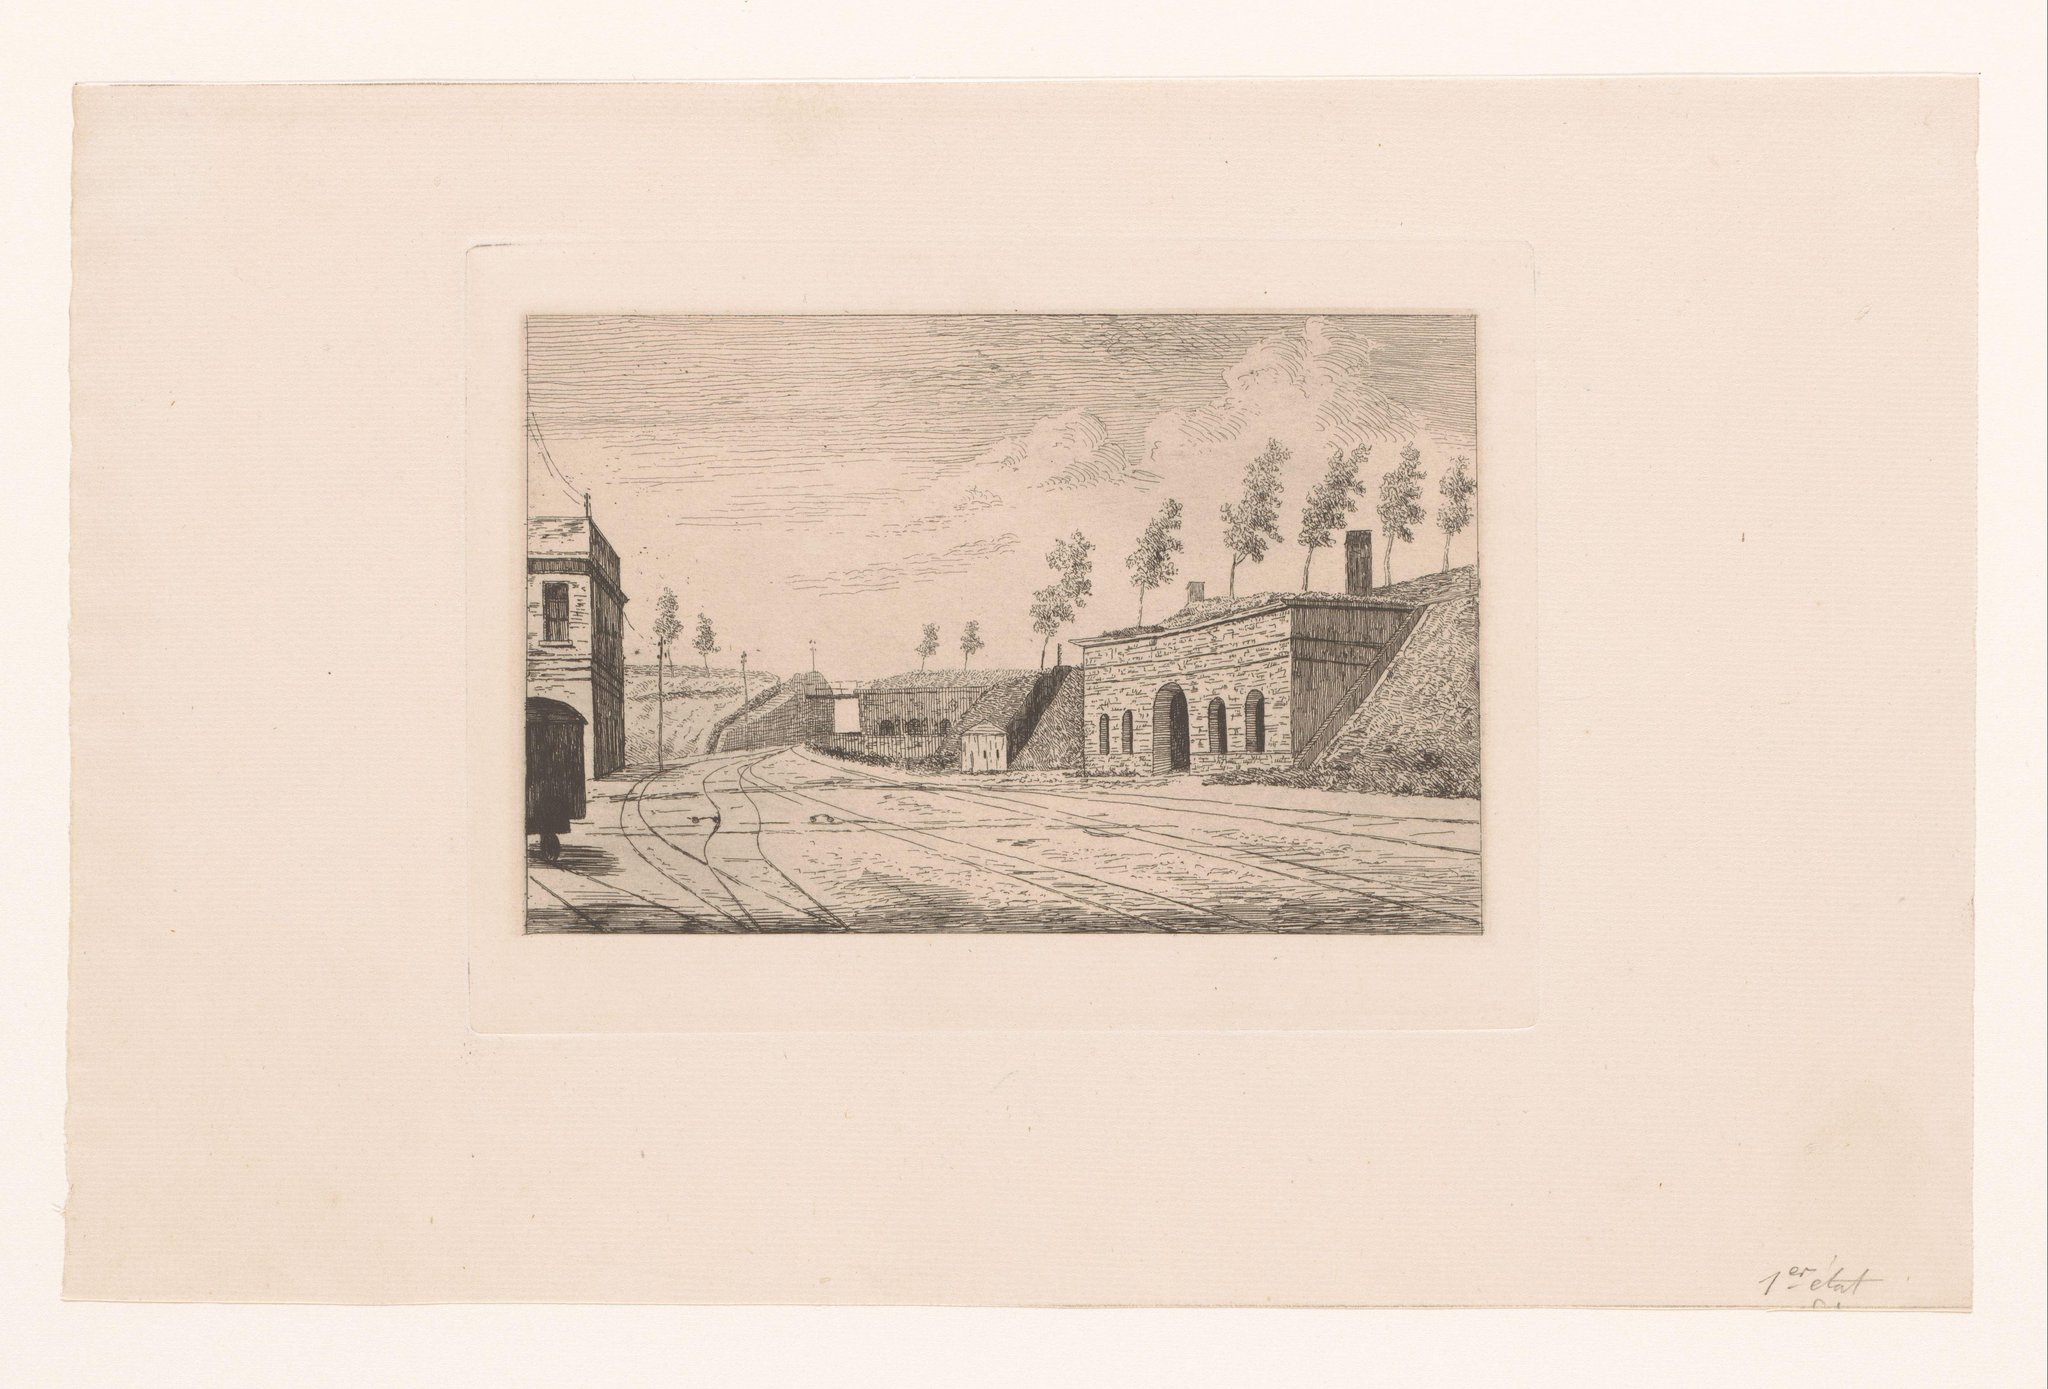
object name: print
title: Vestingwerken van Mons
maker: léon dolez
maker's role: print maker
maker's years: 1837-1902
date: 1875-1878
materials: paper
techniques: etching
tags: city-view, and landscape with man-made constructions, village-gate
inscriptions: collector's mark: Lugt 2228